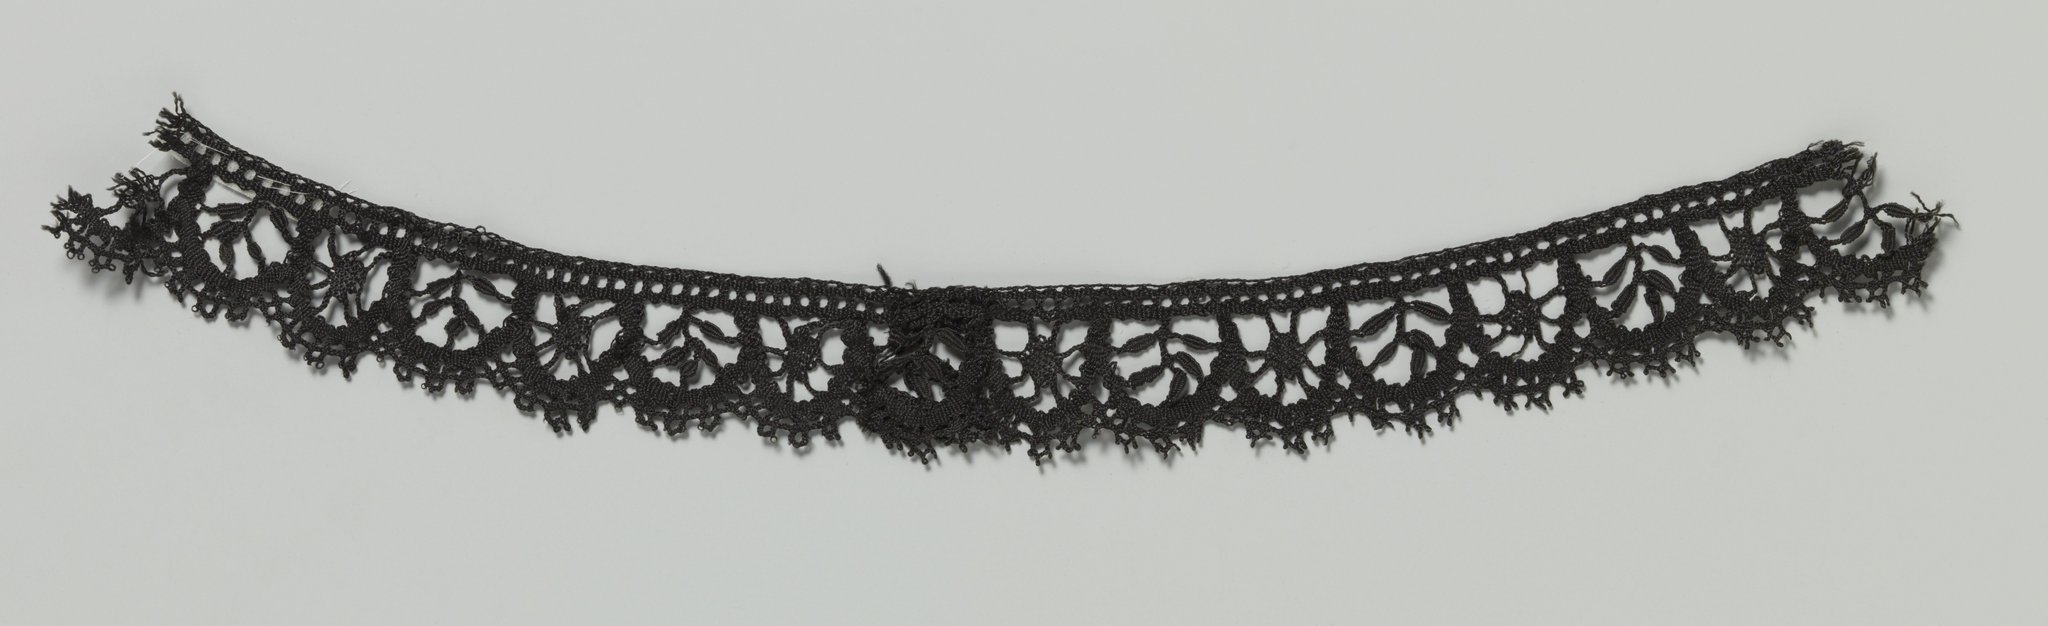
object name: strip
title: Strook kloskant met boogjesrand waarin afwisselend een bladertakje en een rondje tussen spaken staan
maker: Anonymous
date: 1900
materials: silk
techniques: lace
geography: belgium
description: Strook zwarte kloskant, Cluny-kant. Het zich herhalende patroon bestaat uit een boogjesrand, waarbij de boogjes teven de schulpen vormen. In elk boogje staat afwisselend een takje met vijf blaadjes en een rondje tussen spaken. De bandjes die de boogjes vormen zijn gemaakt in linnenslag. De rondjes erin zijn gemaakt in netslag en de blaadjes aan de takjes zijn gemaakt in vormslag. De motieven zijn met elkaar verbonden door een vlechtengrond. Langs de onderzijde hangen aan elk boogje drie lobjes, gemaakt met vlechtjes en afgewerkt met enkele picots. De bovenzijde van de strook is recht afgewerkt.